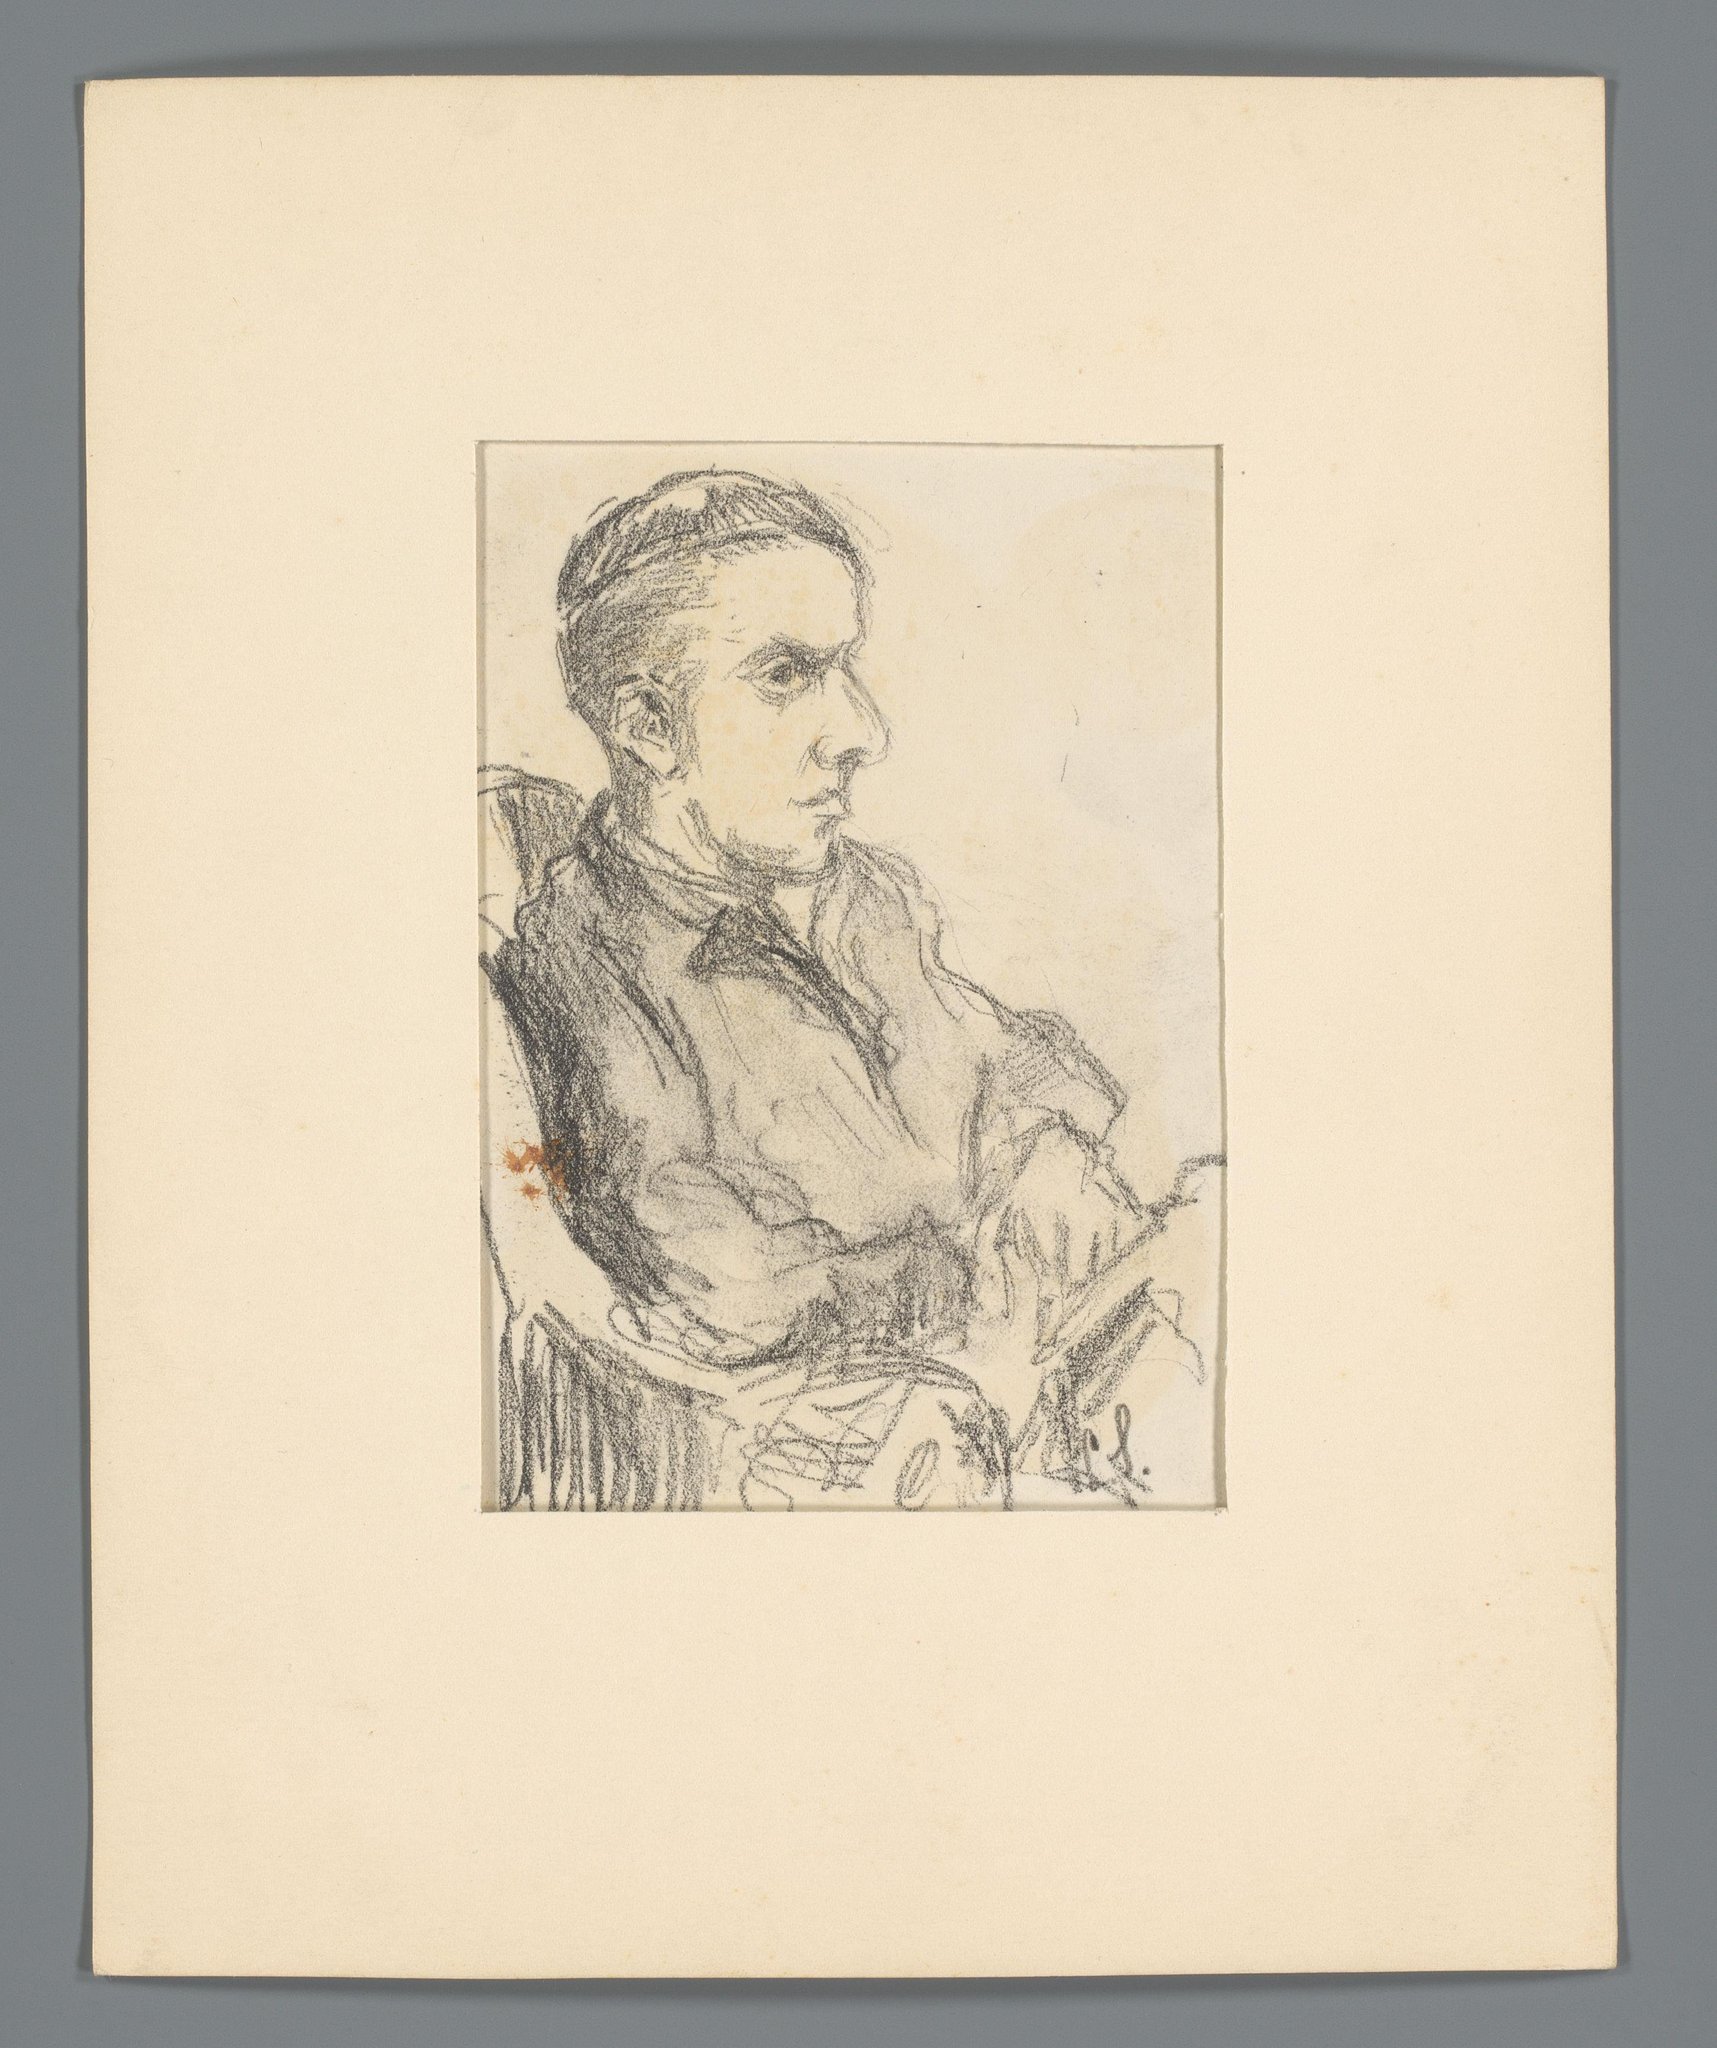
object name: drawing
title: Portret van een man, mogelijk C.F. van Schagen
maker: louis stutterheim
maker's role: draughtsman, painter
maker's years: 1873-1943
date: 1883-1943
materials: chalk, paper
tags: historical persons not known by name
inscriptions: signature: ‘L.S.’